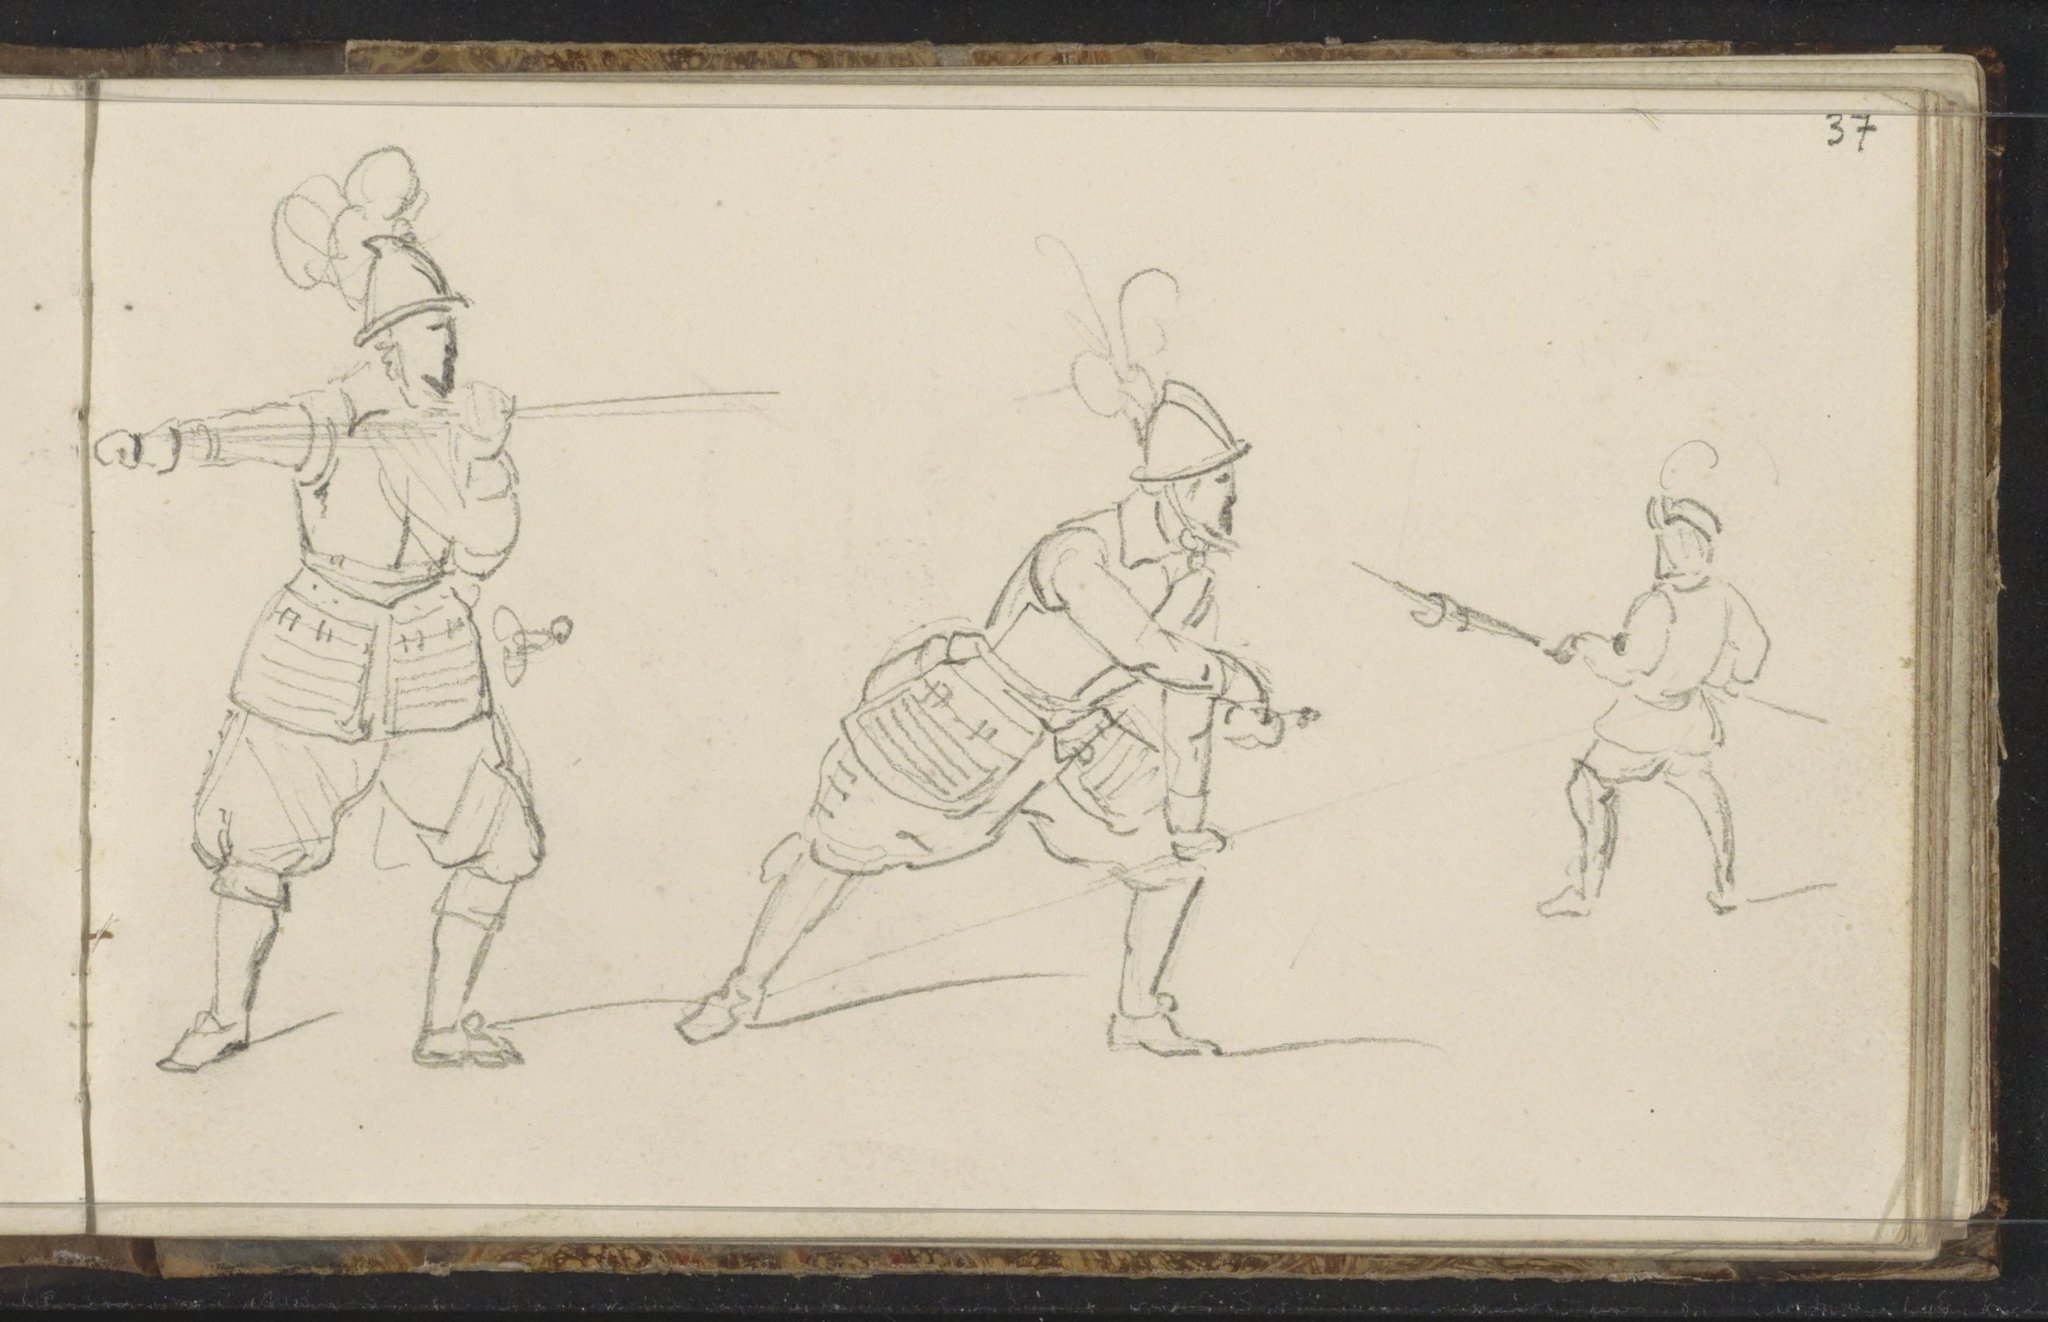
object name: sketchbook leaf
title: Soldaat met een lans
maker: willem hendrik schmidt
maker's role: draughtsman, painter, print maker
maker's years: 1809-1849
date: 1819-1849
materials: paper, pencil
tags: helved weapons, polearms (for striking, hacking, thrusting): lance, the soldier; the soldier's life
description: Blad 37 recto uit een schetsboek met 60 bladen.